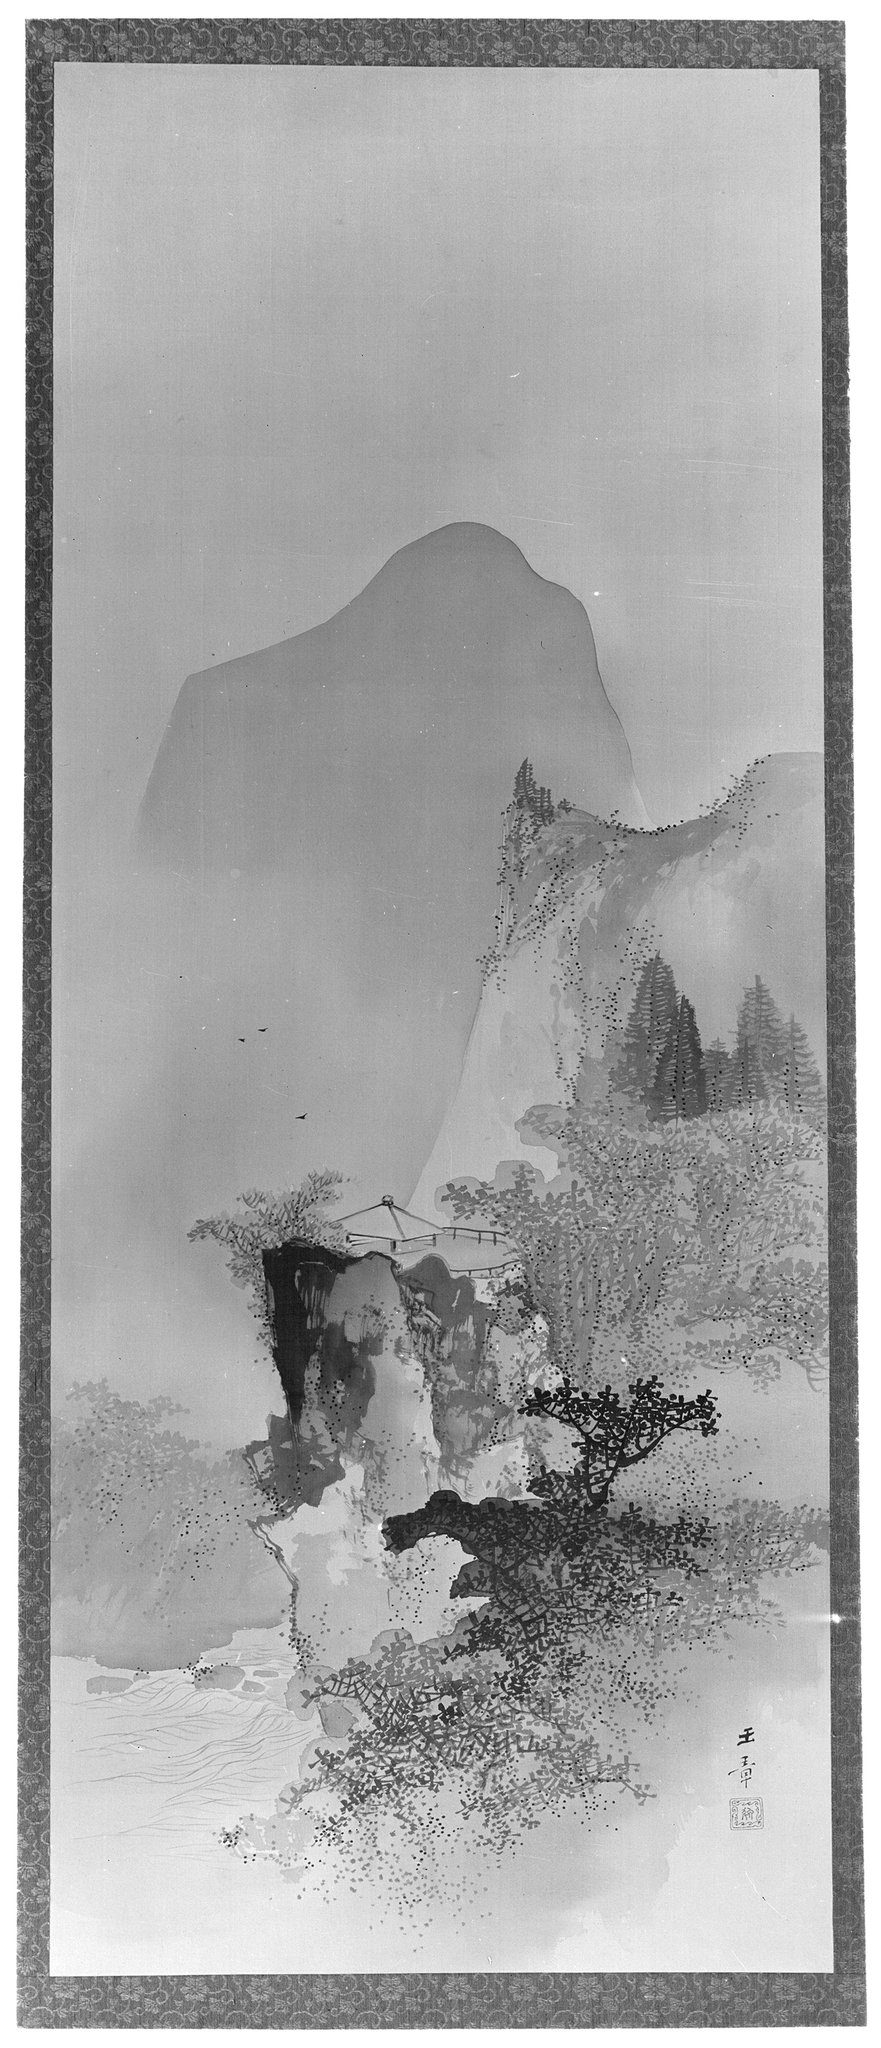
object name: painting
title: Spring Landscape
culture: japanese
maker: kawabata gyokushō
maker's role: artist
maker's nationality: japanese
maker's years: 1842-1913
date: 1901-2000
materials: ink, silk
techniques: painting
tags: mountains,landscapes